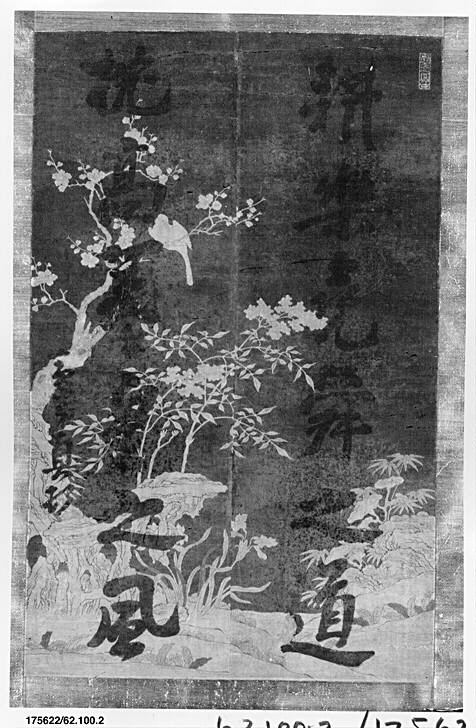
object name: vertical scroll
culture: chinese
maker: unidentified artist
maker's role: artist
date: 1601-1633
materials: silk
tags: birds,trees